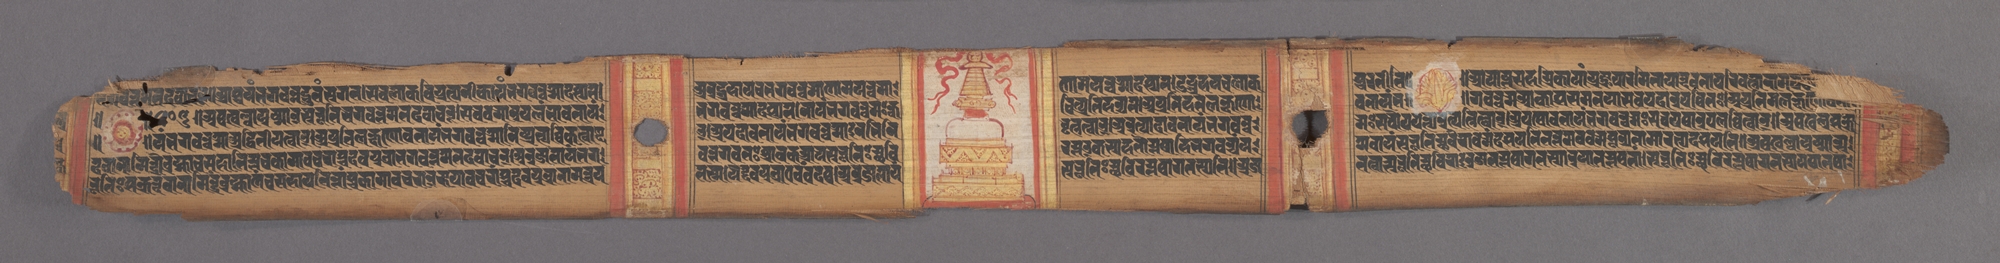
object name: folio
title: Stupa, Leaf from a dispersed Ashtasahasrika Prajnaparamita (Perfection of Wisdom) Manuscript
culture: indian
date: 1101-1200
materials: ink, leaf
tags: buddhism,stupas